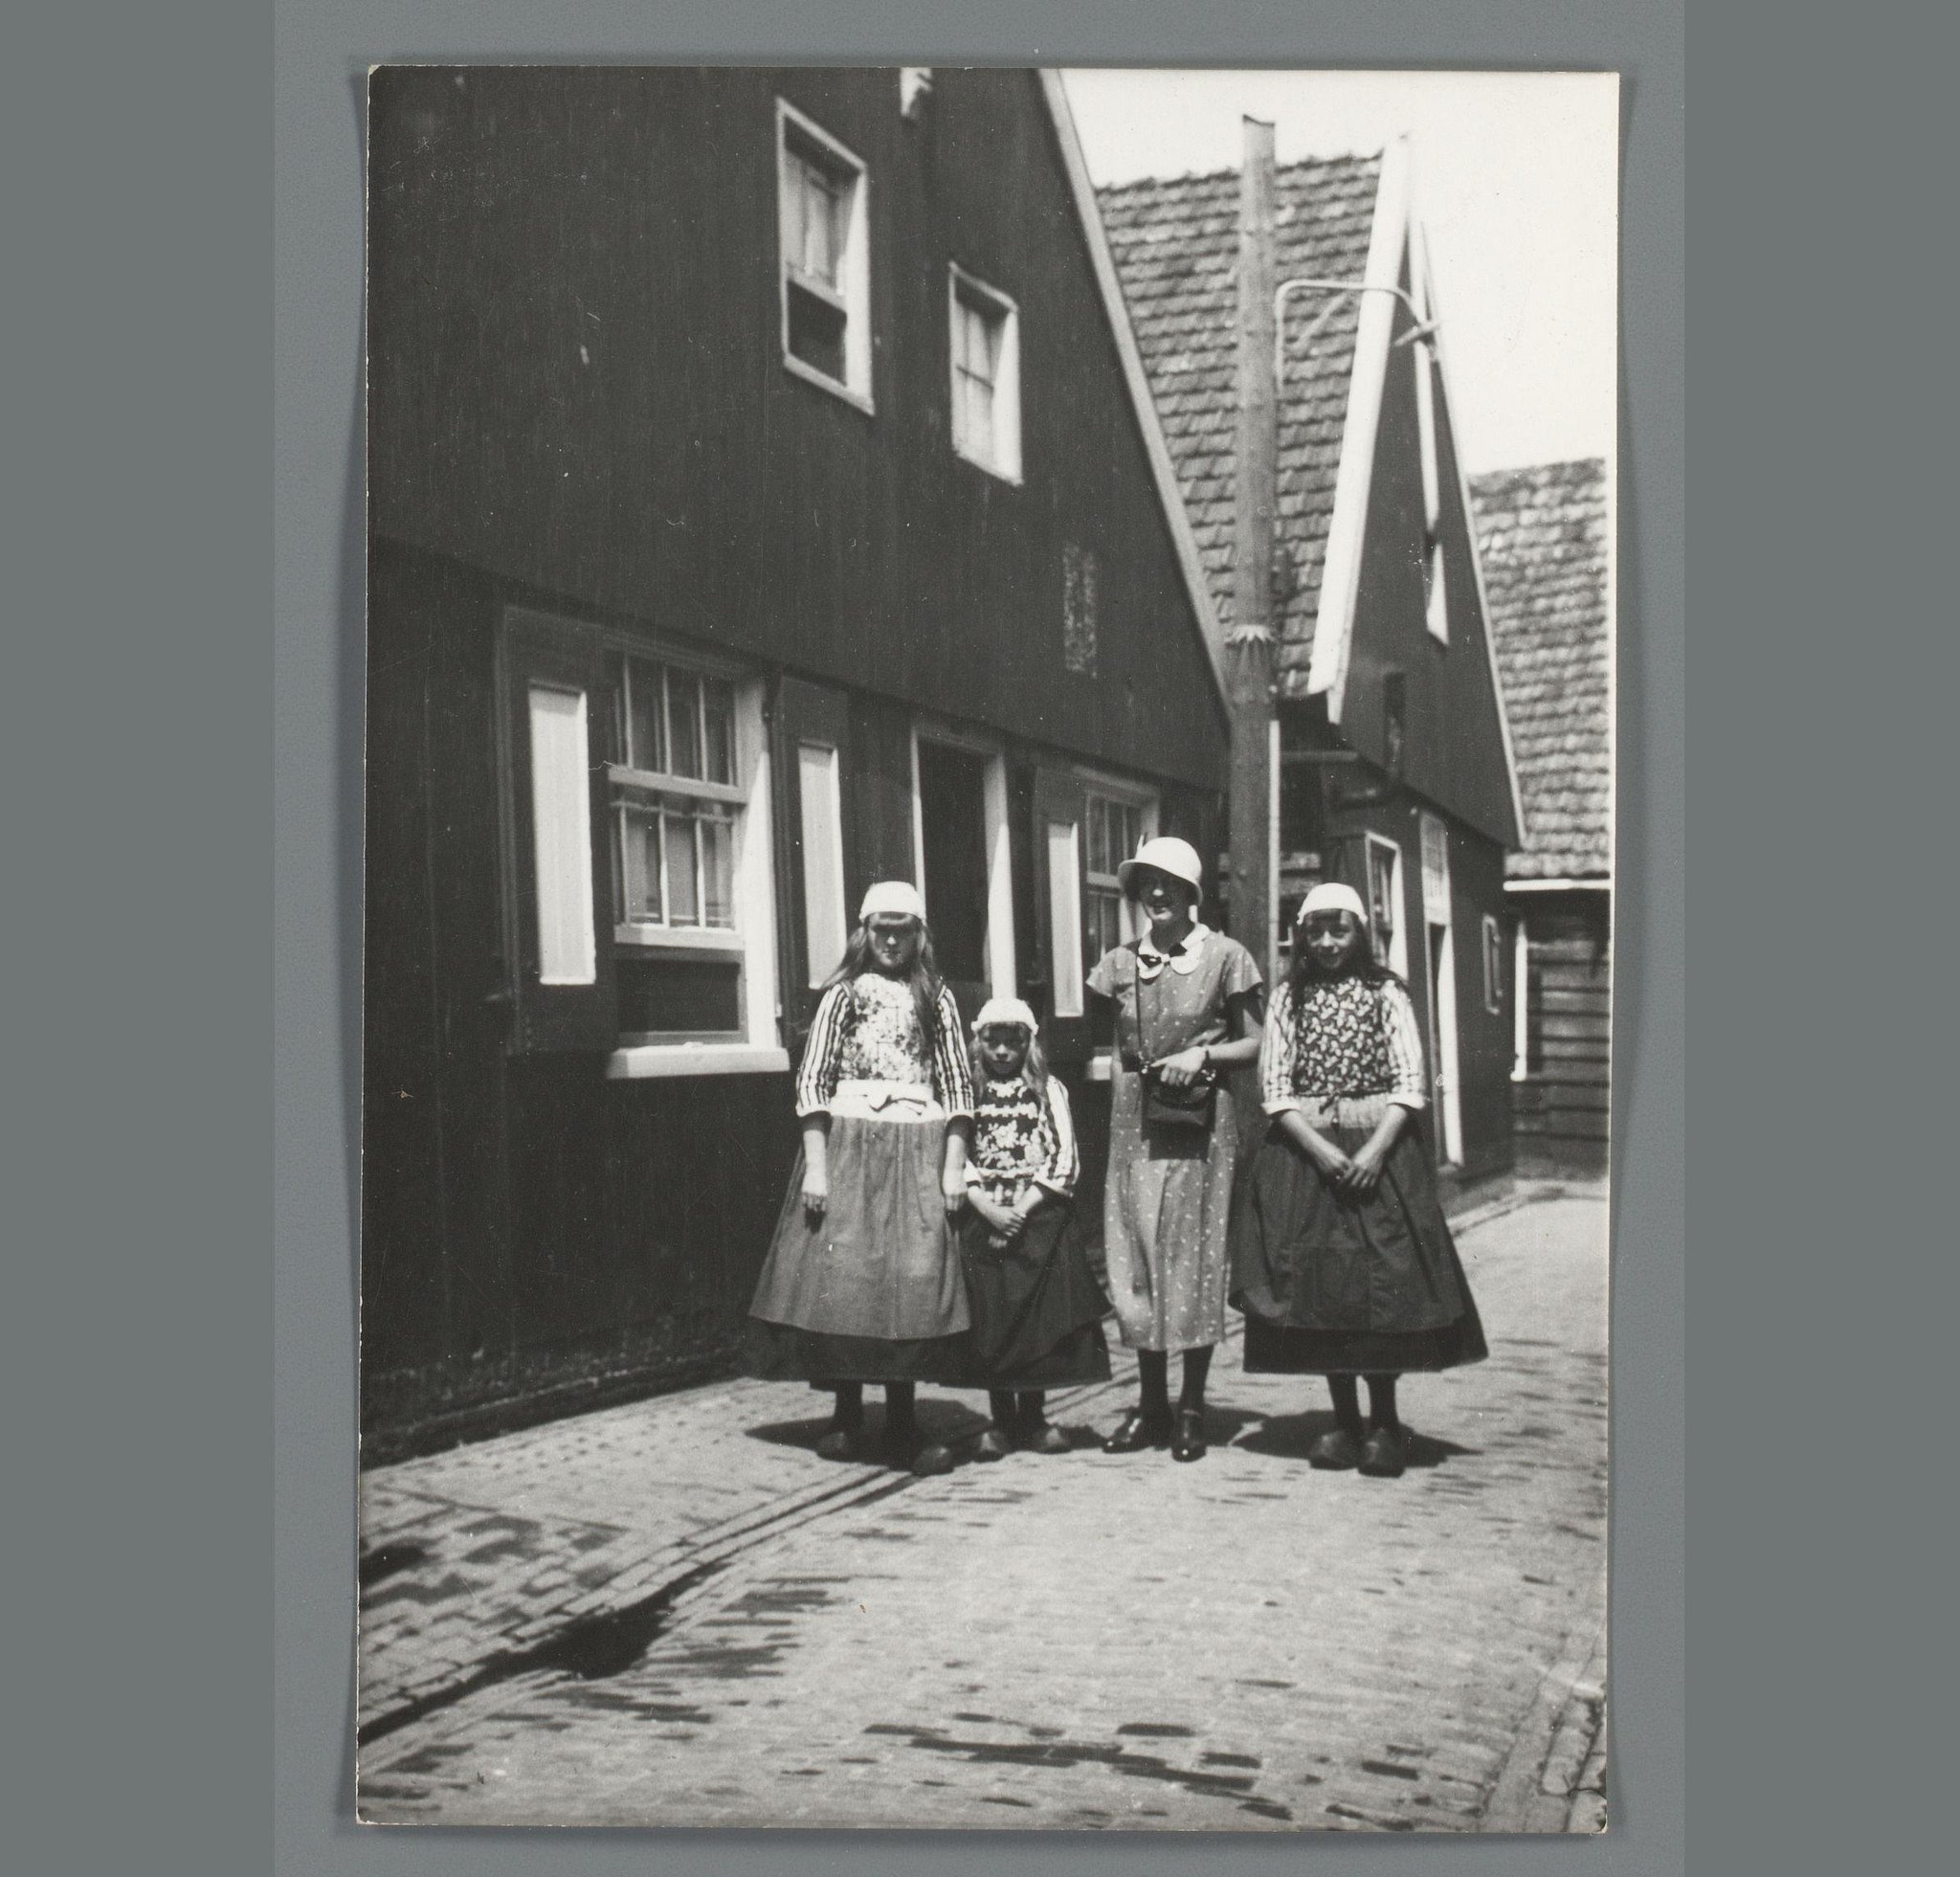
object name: photograph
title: Groepsportret van een onbekende vrouw en drie onbekende meisjes in Marker klederdracht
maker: Anonymous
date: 1920-1950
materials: paper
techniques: gelatin silver print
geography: marken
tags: girl (child between toddler and youth), folk costume, regional costume, anonymous historical persons portrayed in a group, in a group-portrait